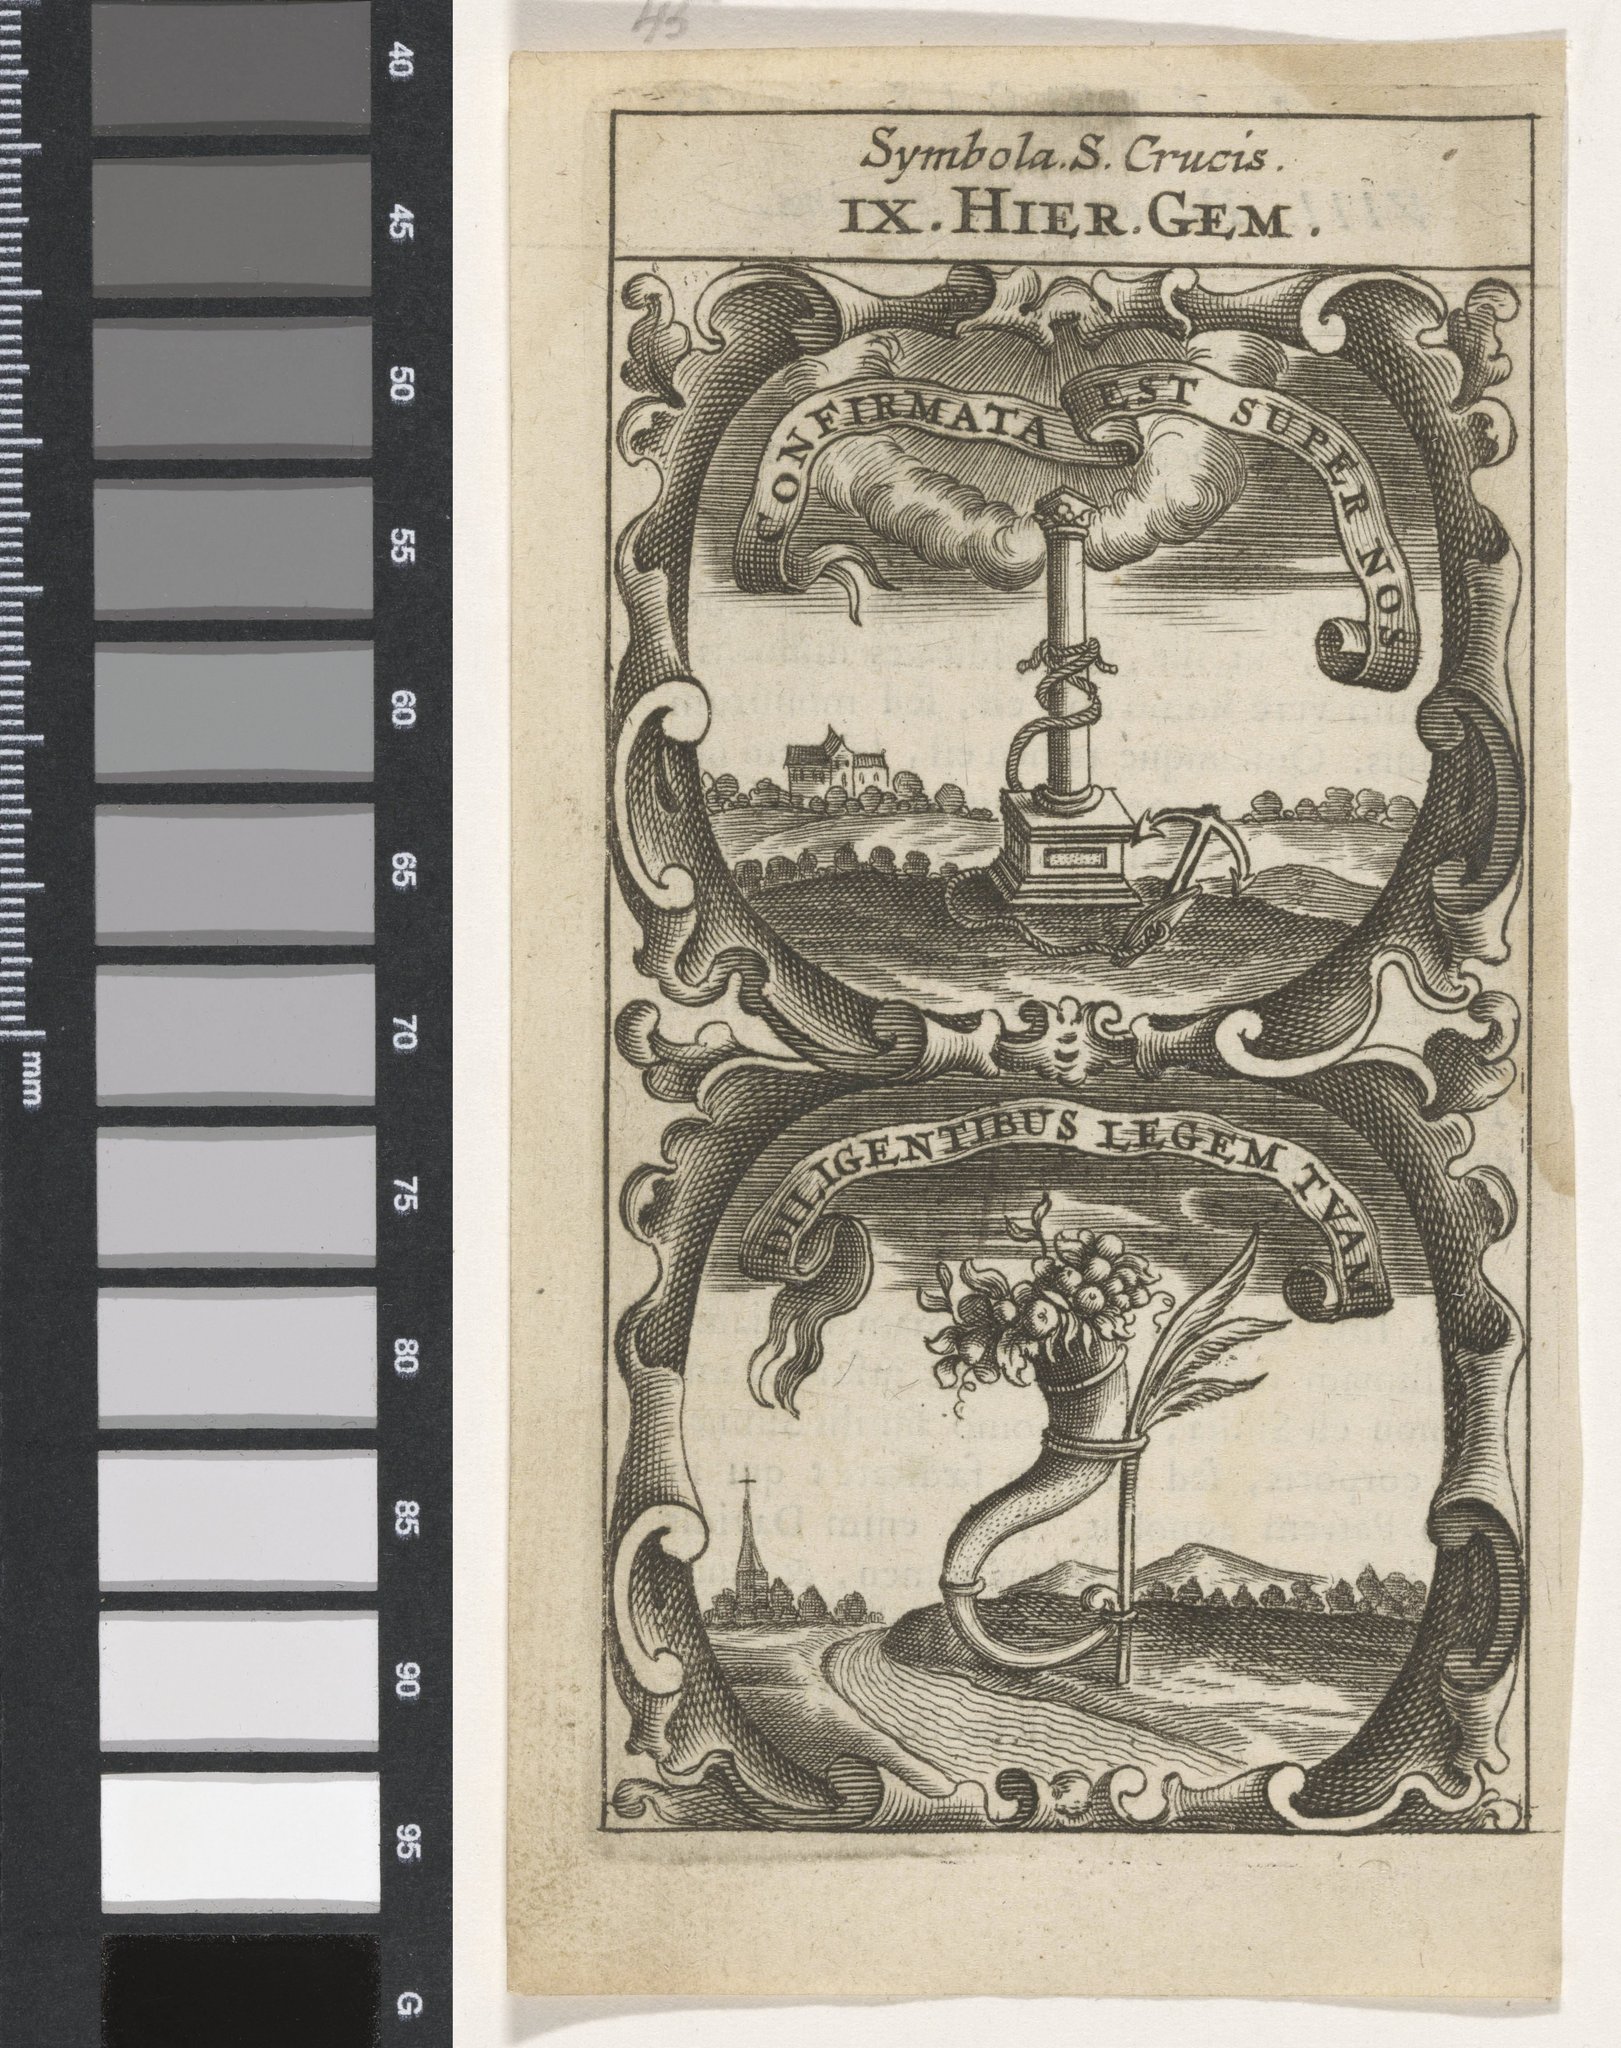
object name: print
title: Zuil met anker / Cornucopia met palmtak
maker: Anonymous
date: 1666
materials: paper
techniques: engraving, letterpress printing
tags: 'cornucopia', horn of plenty, column, pillar ~ architecture, parts of ship's exterior: anchor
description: Pagina uit Jacob Typotius, Symbola Divina & Humana Pontificum Imperatorum Regum. Arnhem, J.F. Hagen, 1666 of uit de titeluitgave van 1669 of 1679. Het werk van Typotius werd voor het eerst uitgegeven in 1601 met prenten van Aegidius Sadeler.